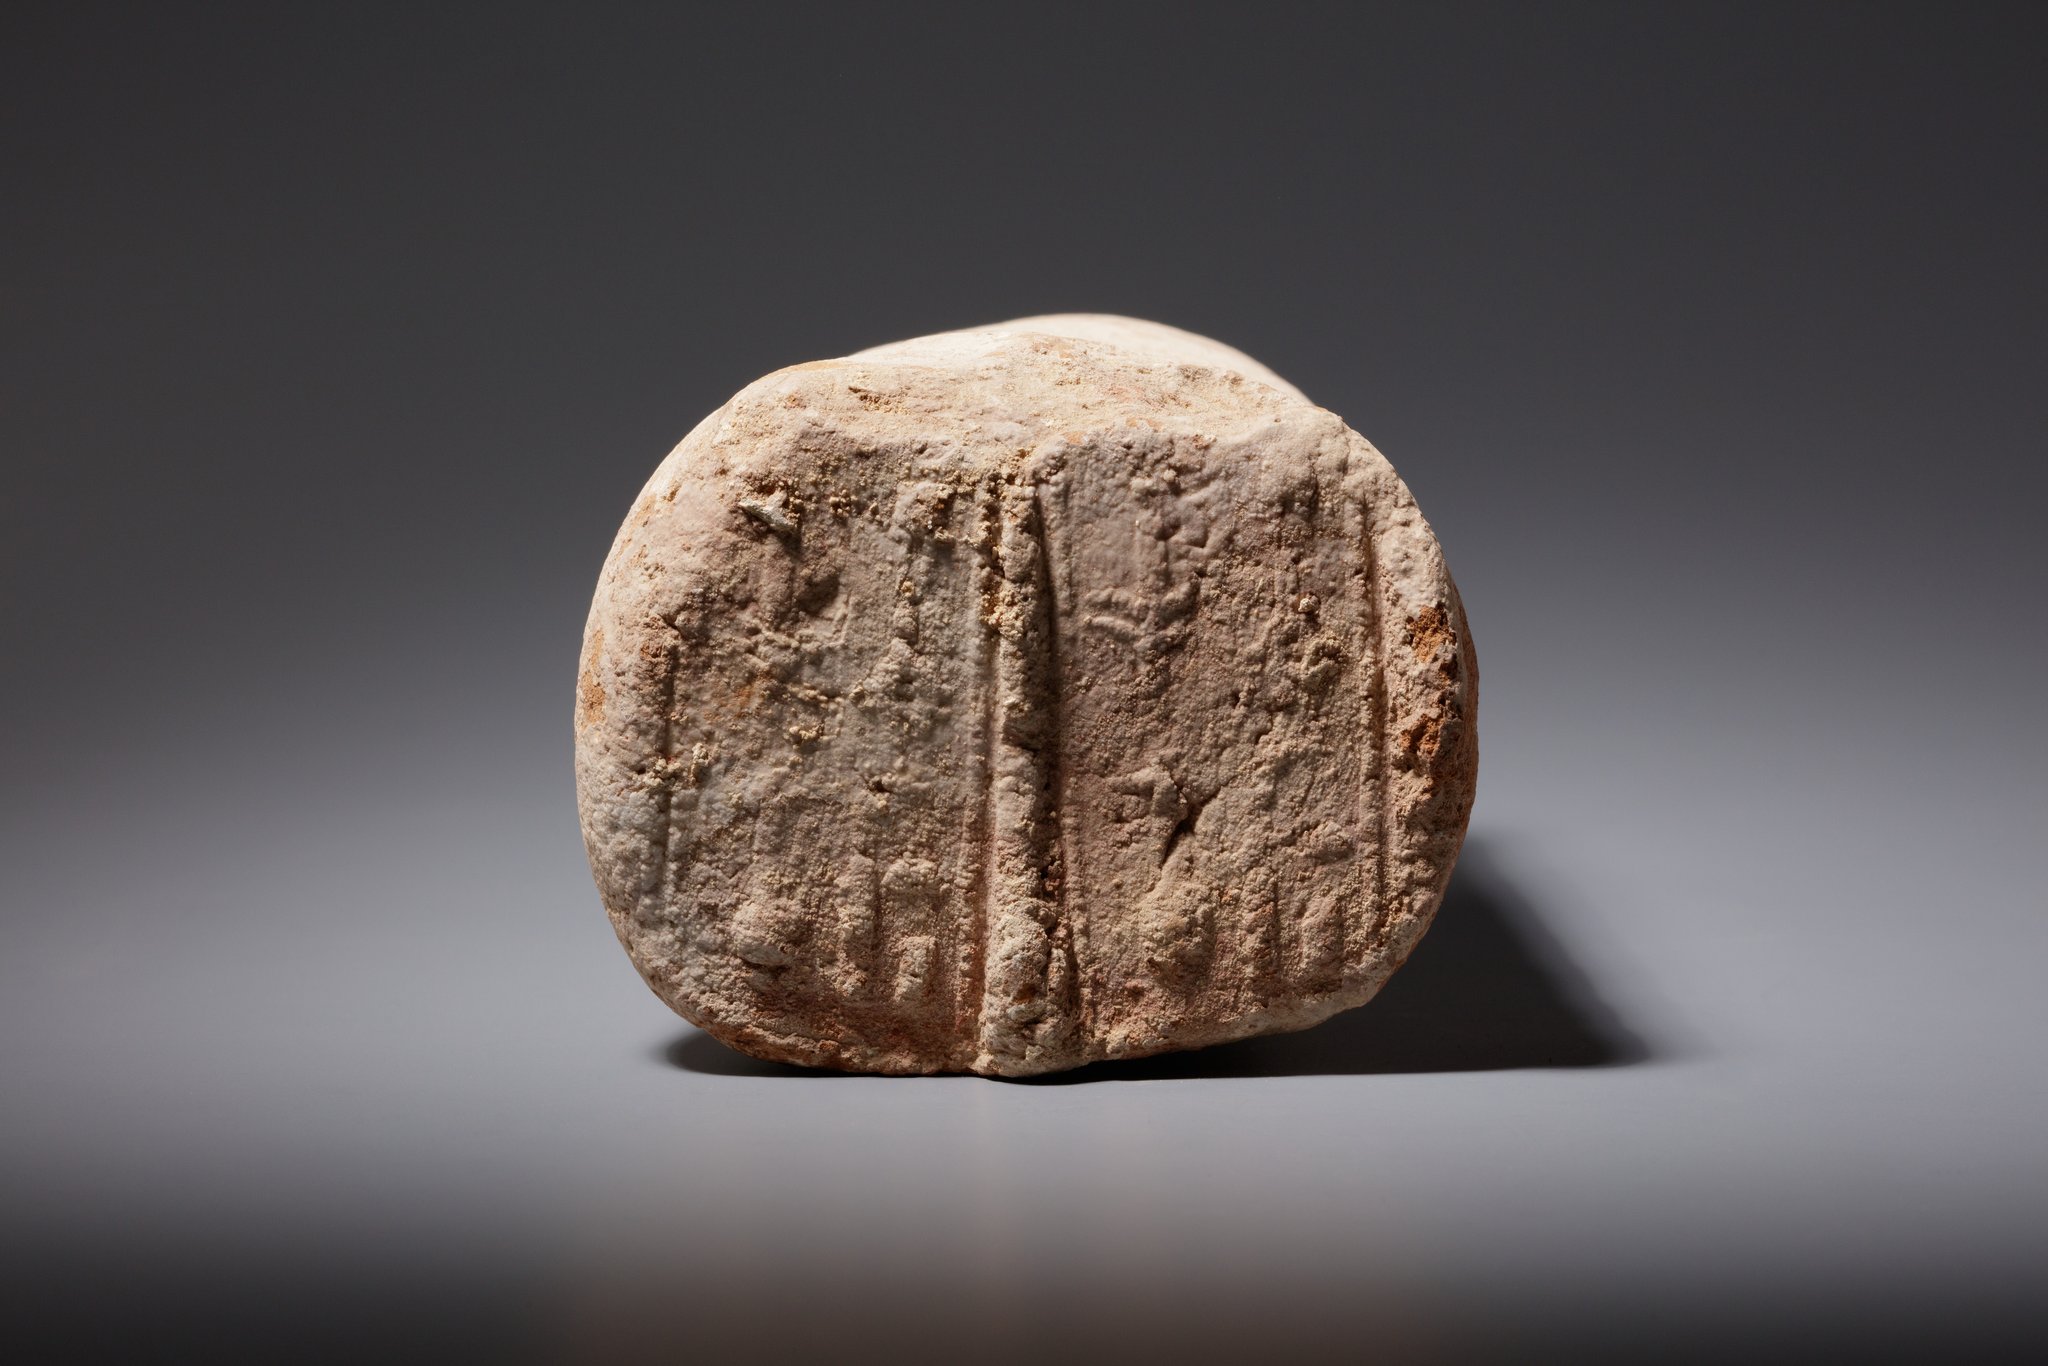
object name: cone, davy 335, neferrenpet, cup bearer, king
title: Funerary Cone of the Royal Cup-Bearer Neferrenpet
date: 1390-1352 BCE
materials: pottery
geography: egypt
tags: hieroglyphs